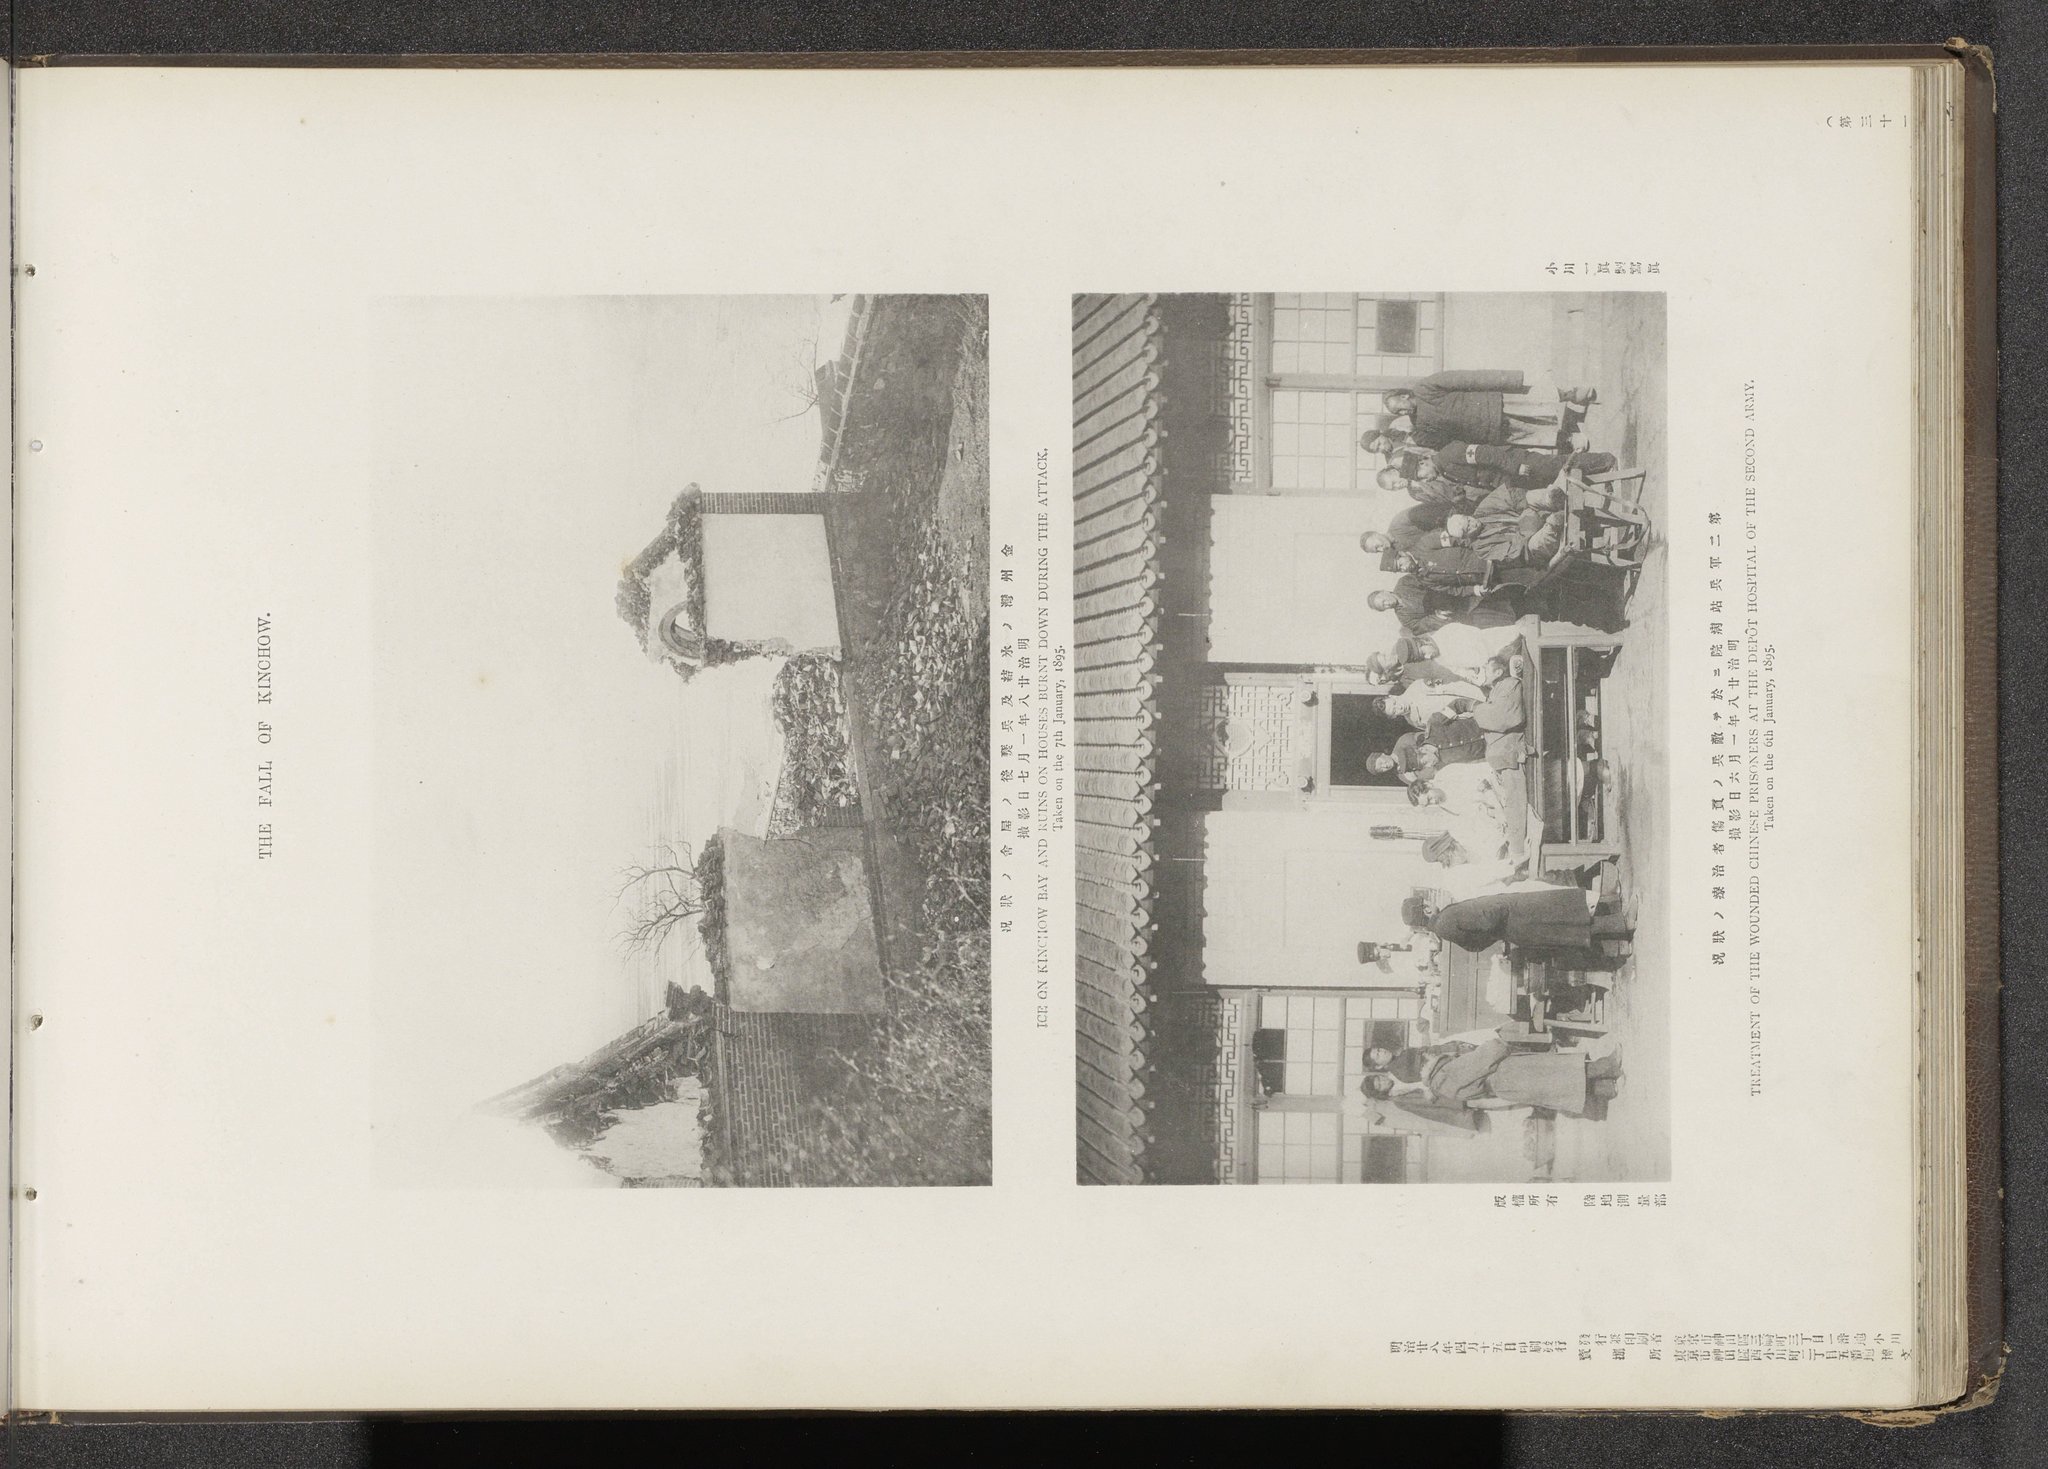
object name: photomechanical print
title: Twee afbeeldingen van Chinchow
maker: kazumasa ogawa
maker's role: auteur, fotograaf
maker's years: 1860-1929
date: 1895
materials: paper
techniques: photograph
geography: chinchow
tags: care ~ prisoner of war, hospital, ruin of a dwelling, house, castle, etc.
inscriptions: inscription: ‘The fall of Kinchow.’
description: Boven een ruïne te Chinchow, met op de achtergrond de baai, onder de behandeling van Chinese krijgsgevangenen voor het ziekenhuis te Chinchow.